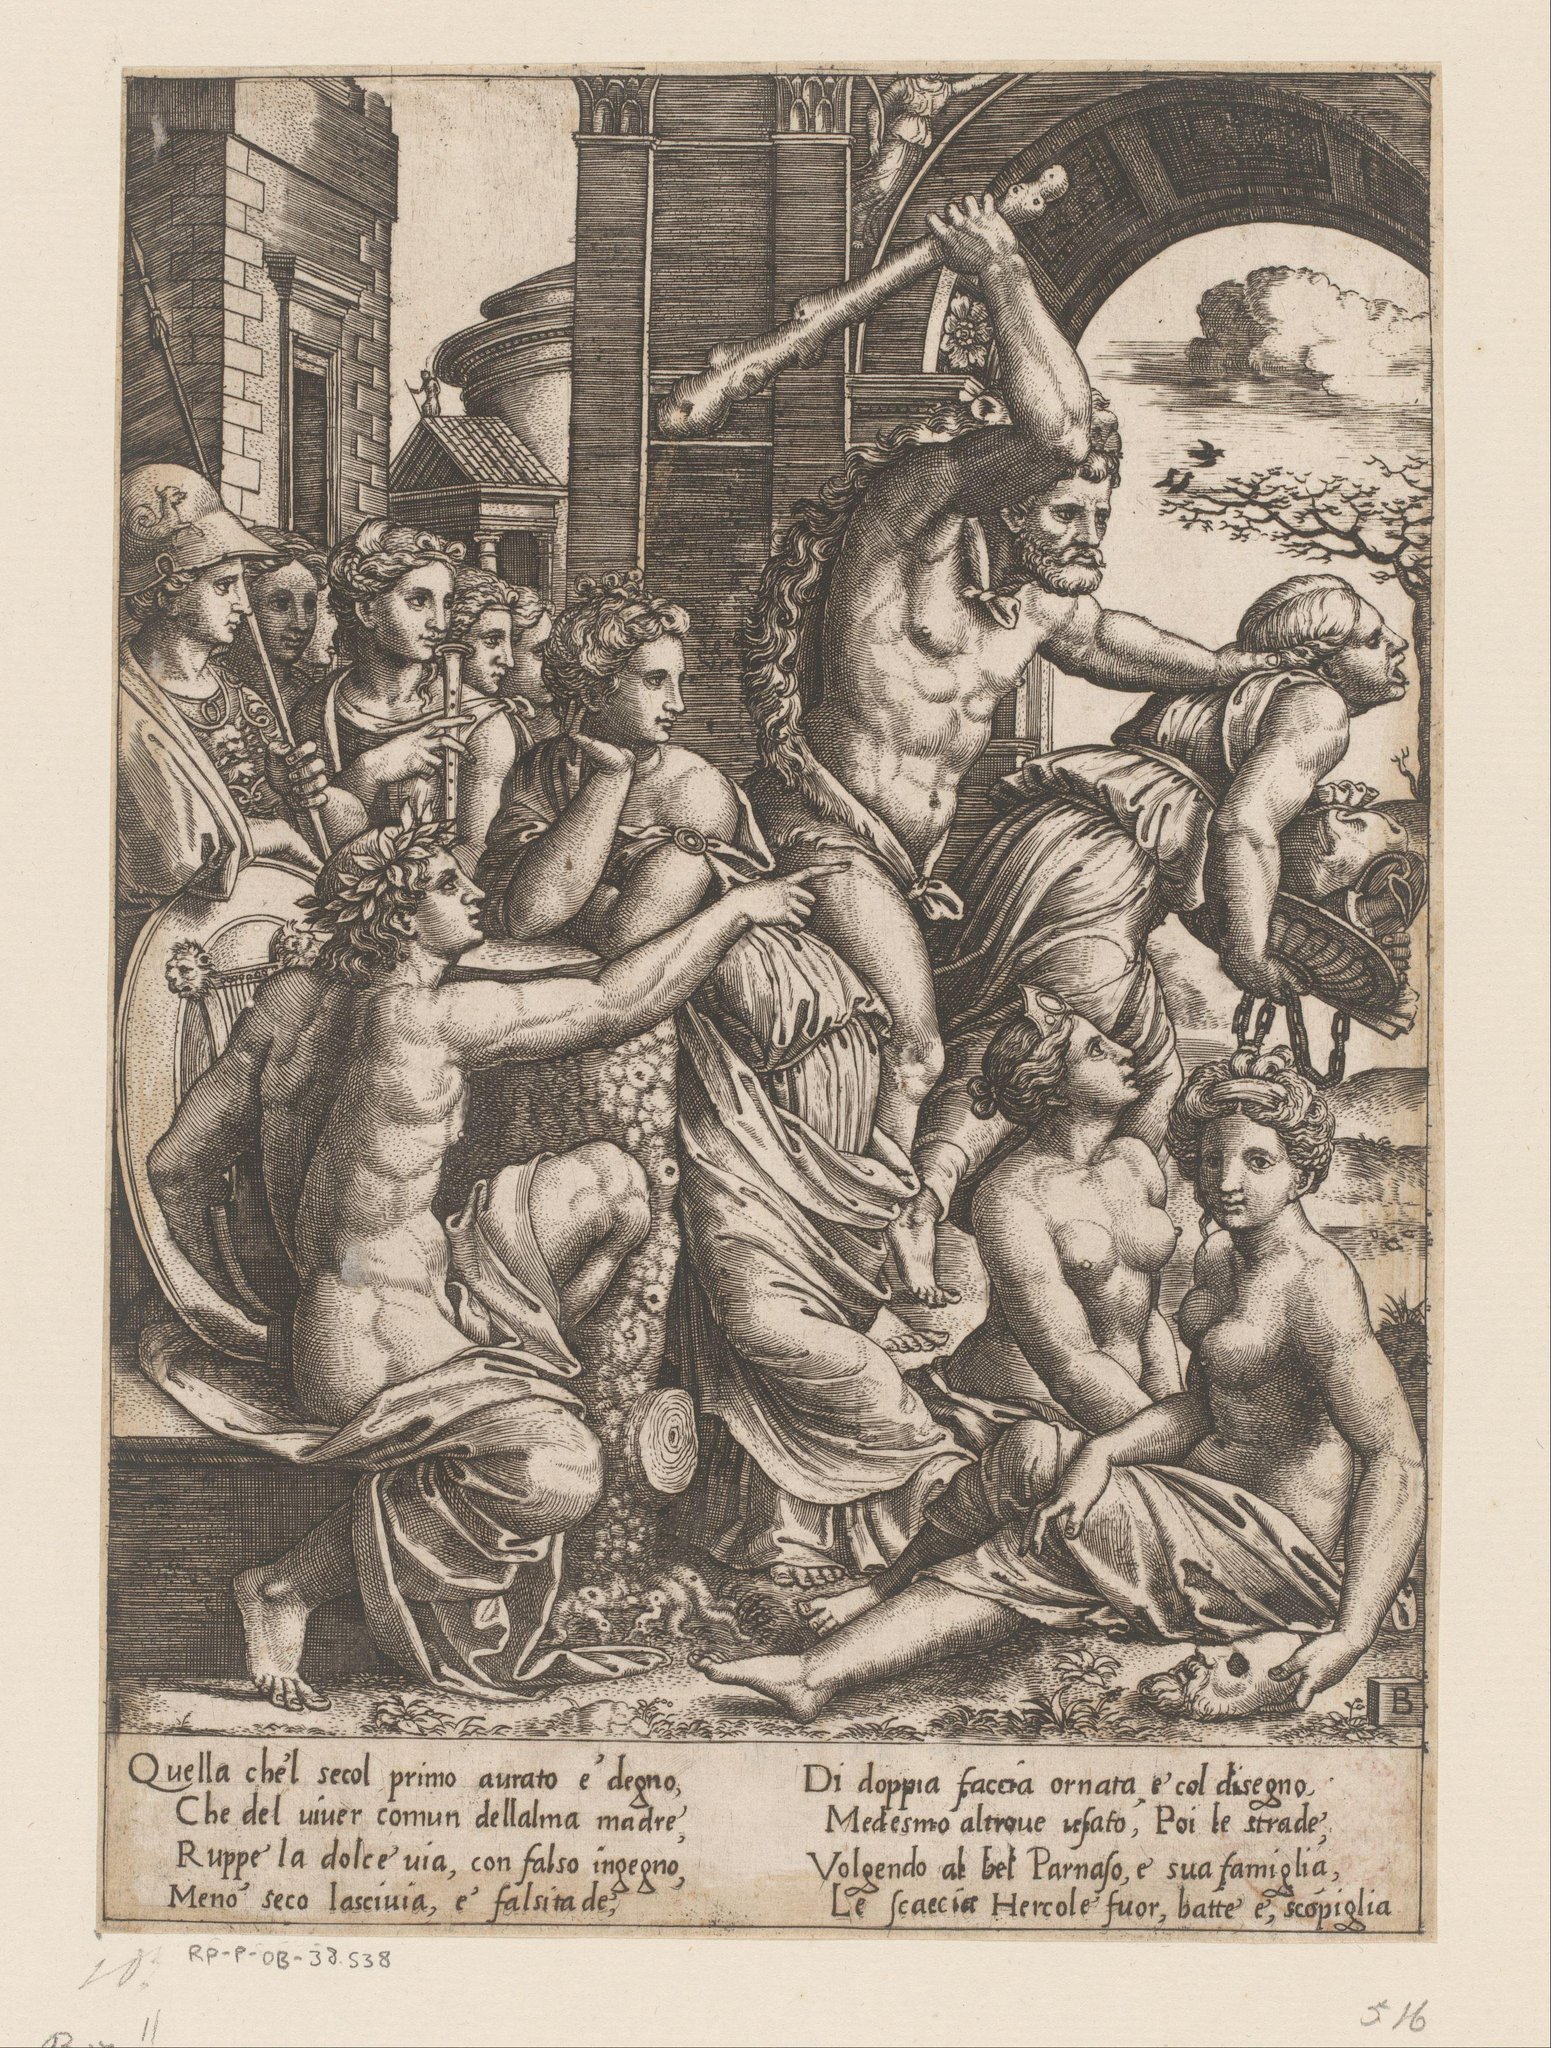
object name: print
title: Afgunst verdreven uit de tempel van de Muzen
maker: meester van de dobbelsteen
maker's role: print maker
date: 1530-1560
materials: paper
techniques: engraving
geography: italy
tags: mask, (story of) hercules (heracles), envy; 'invidia' (ripa) ~ personification of one of the seven deadly sins, (story of) apollo (phoebus), (story of) minerva (pallas, athena), (story of the) muses; 'muse' (ripa), wind instruments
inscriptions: collector's mark: Lugt 240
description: Afgunst (Invidia) in de gedaante van een vrouw wordt door Hercules verdreven uit de tempel van de Muzen. Apollo, Minerva en de Muzen kijken toe. Italiaanse tekst in twee kolommen in ondermarge.